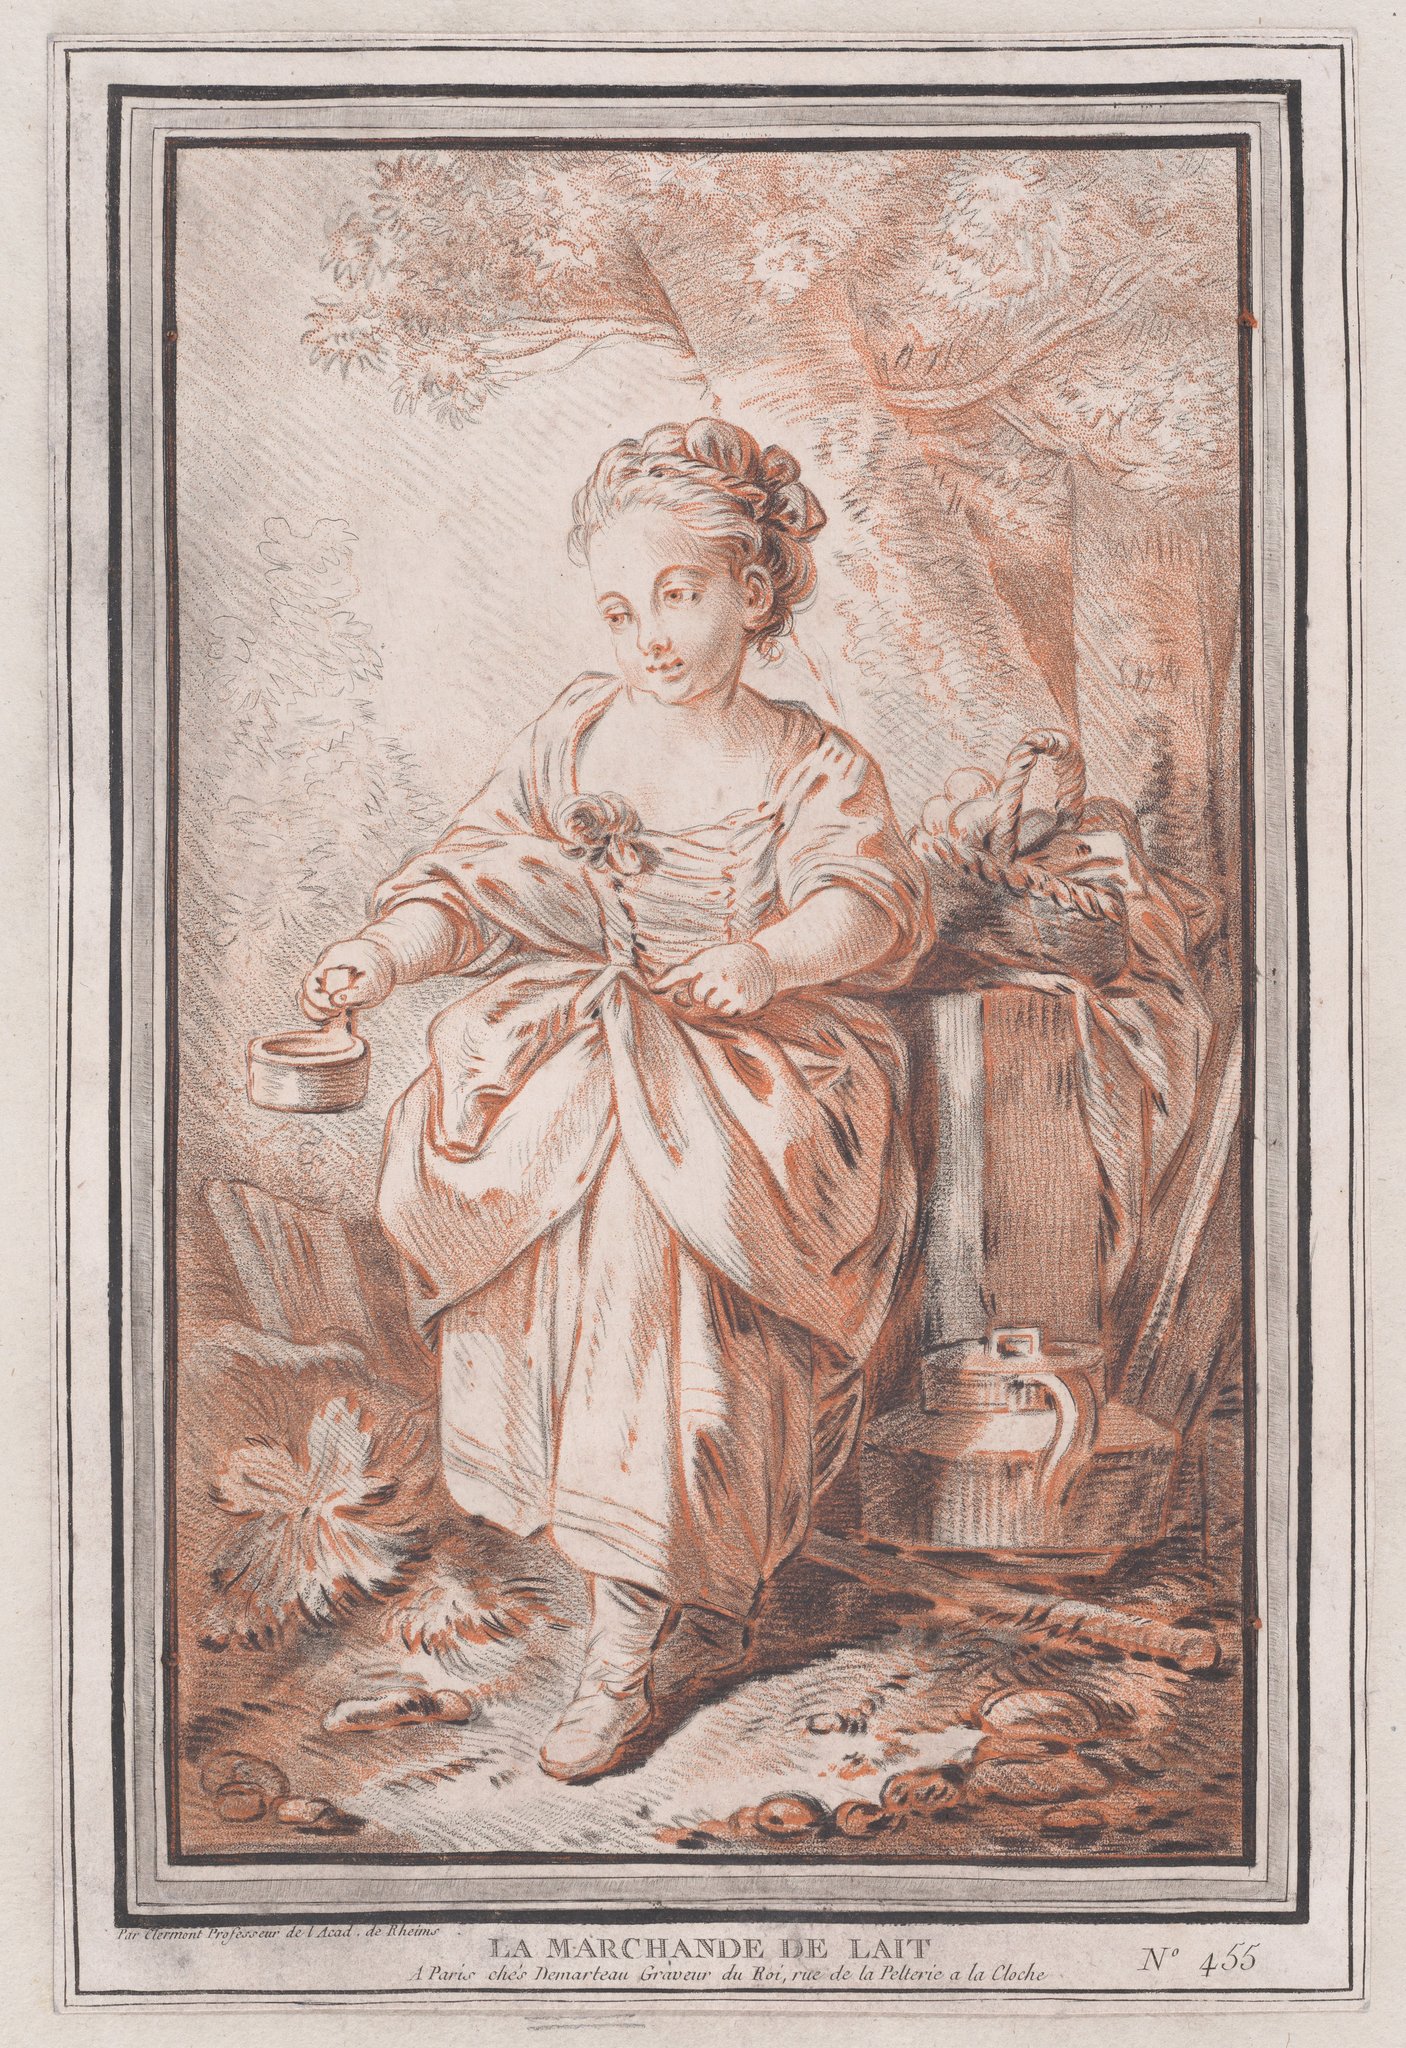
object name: print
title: La Marchande de Lait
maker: gilles demarteau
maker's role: artist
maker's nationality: french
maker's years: 1722-1776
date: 1701-1800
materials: ink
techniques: printmaking, etching, printing